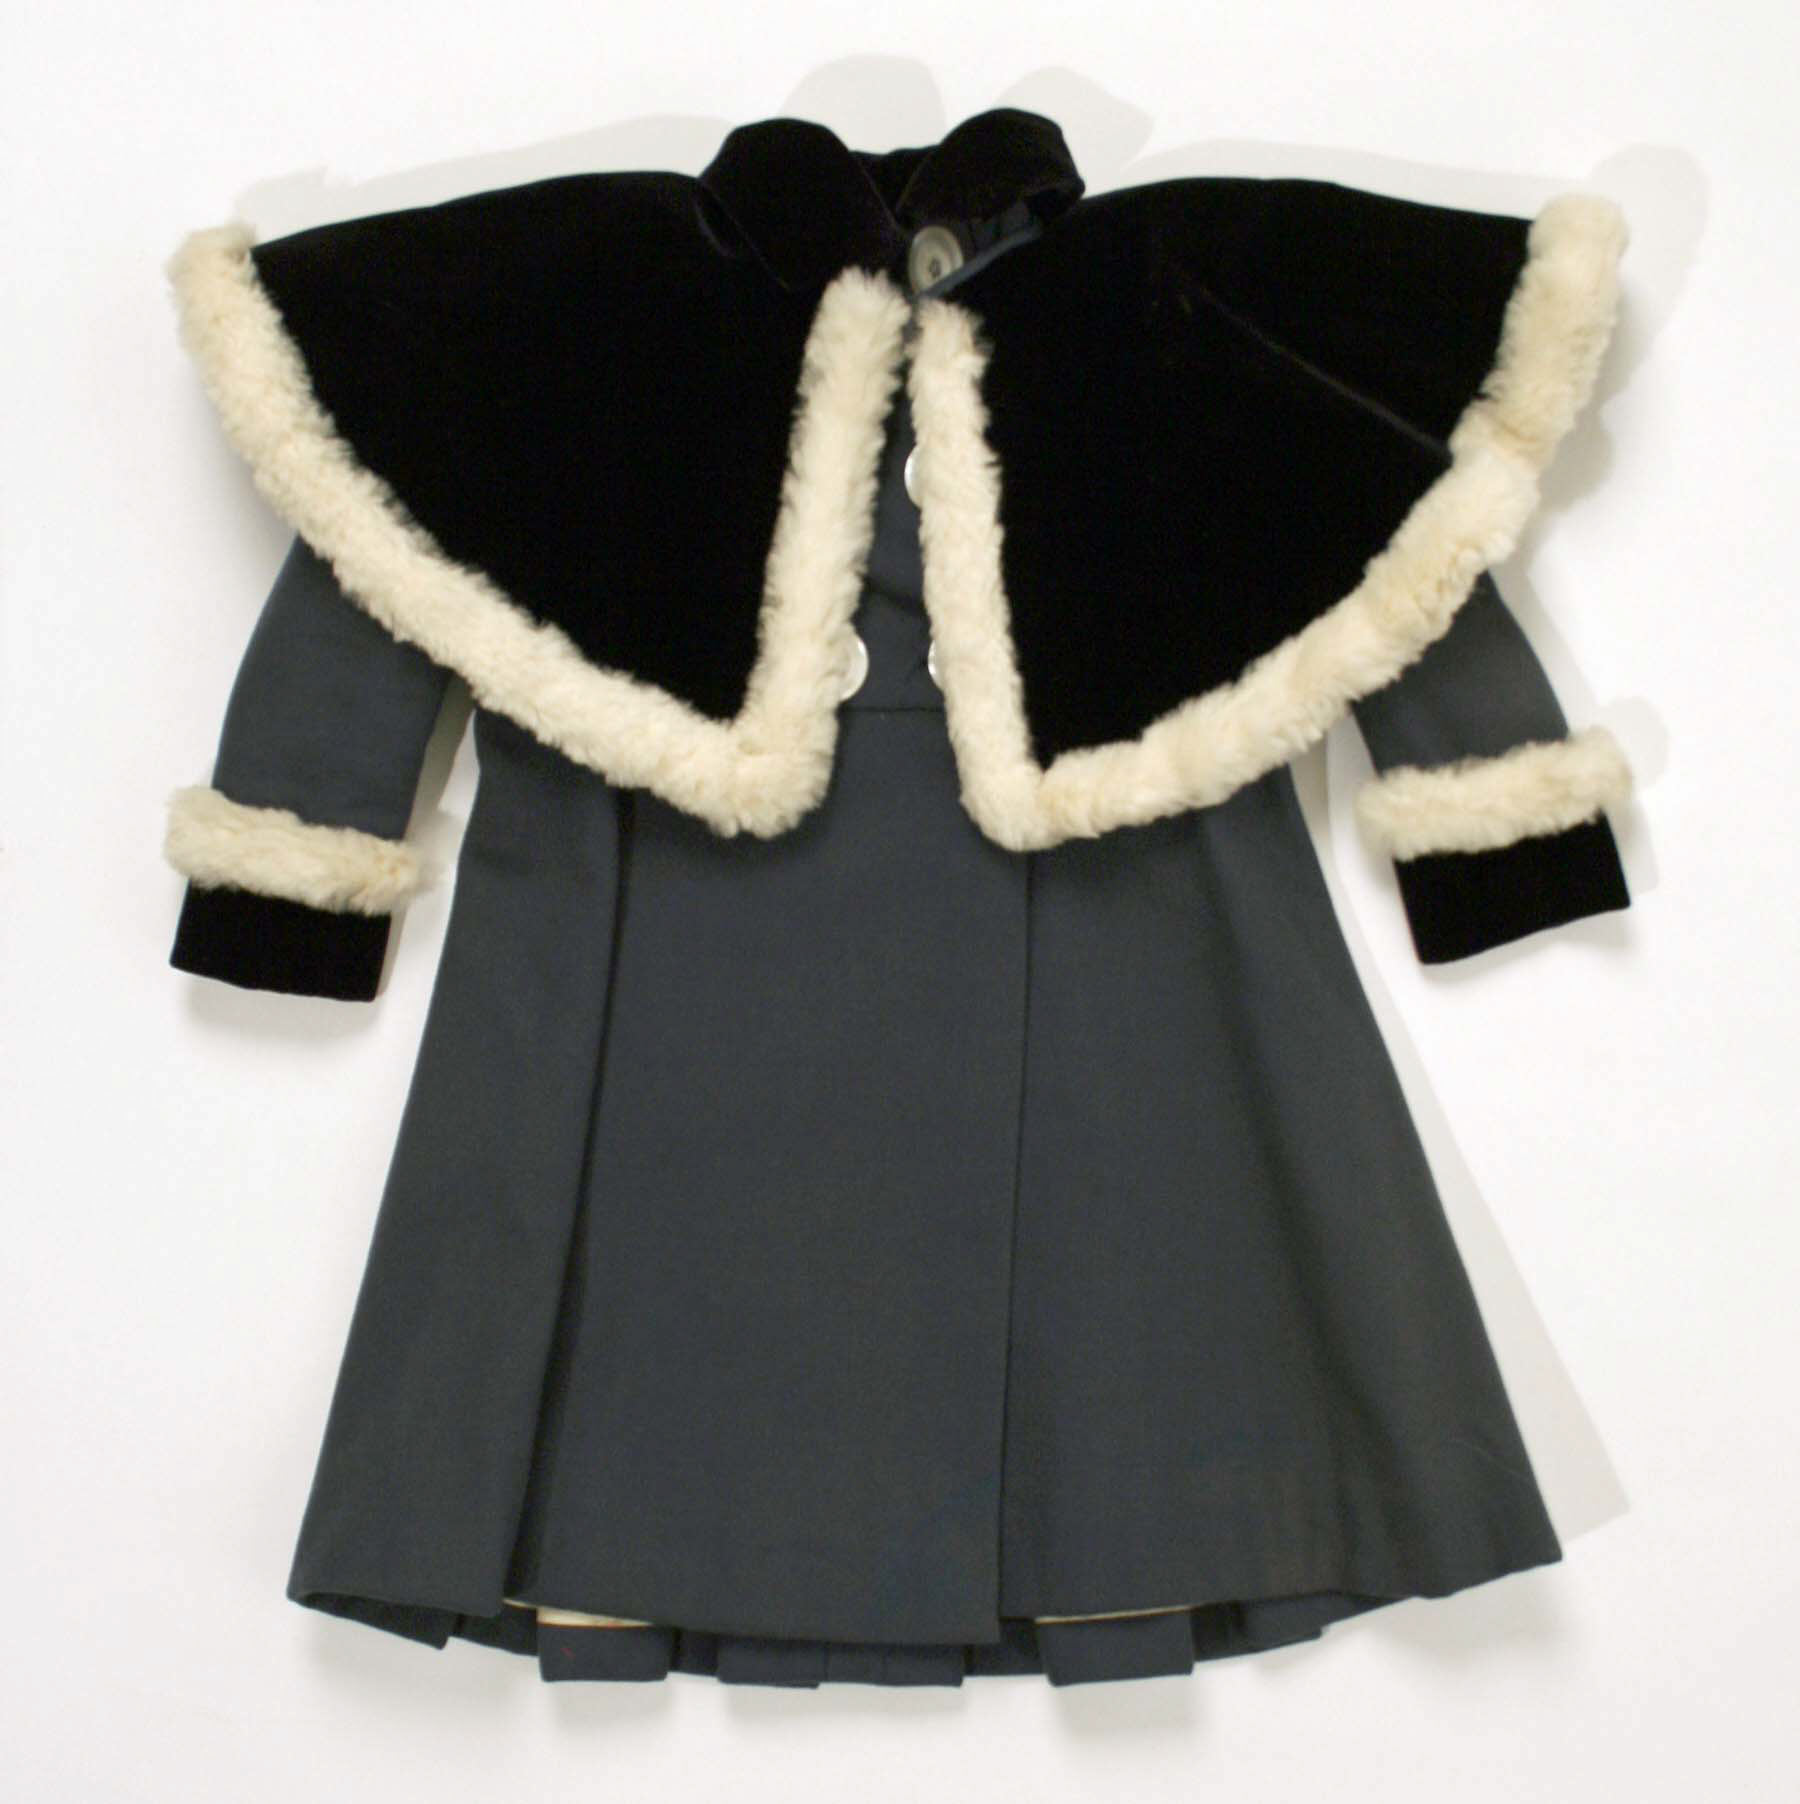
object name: ensemble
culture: french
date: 1895-1899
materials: feather, fur, silk, wool